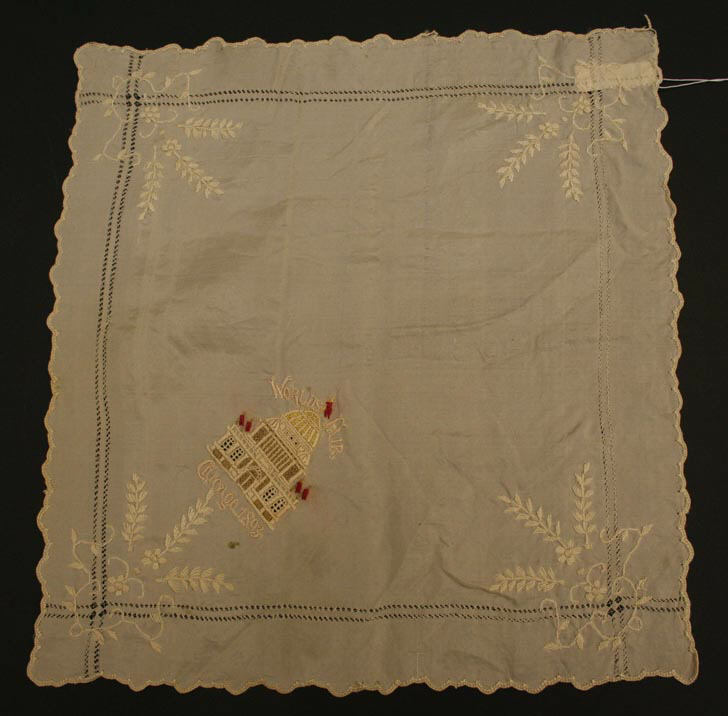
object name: handkerchief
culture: american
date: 1893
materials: silk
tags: palaces